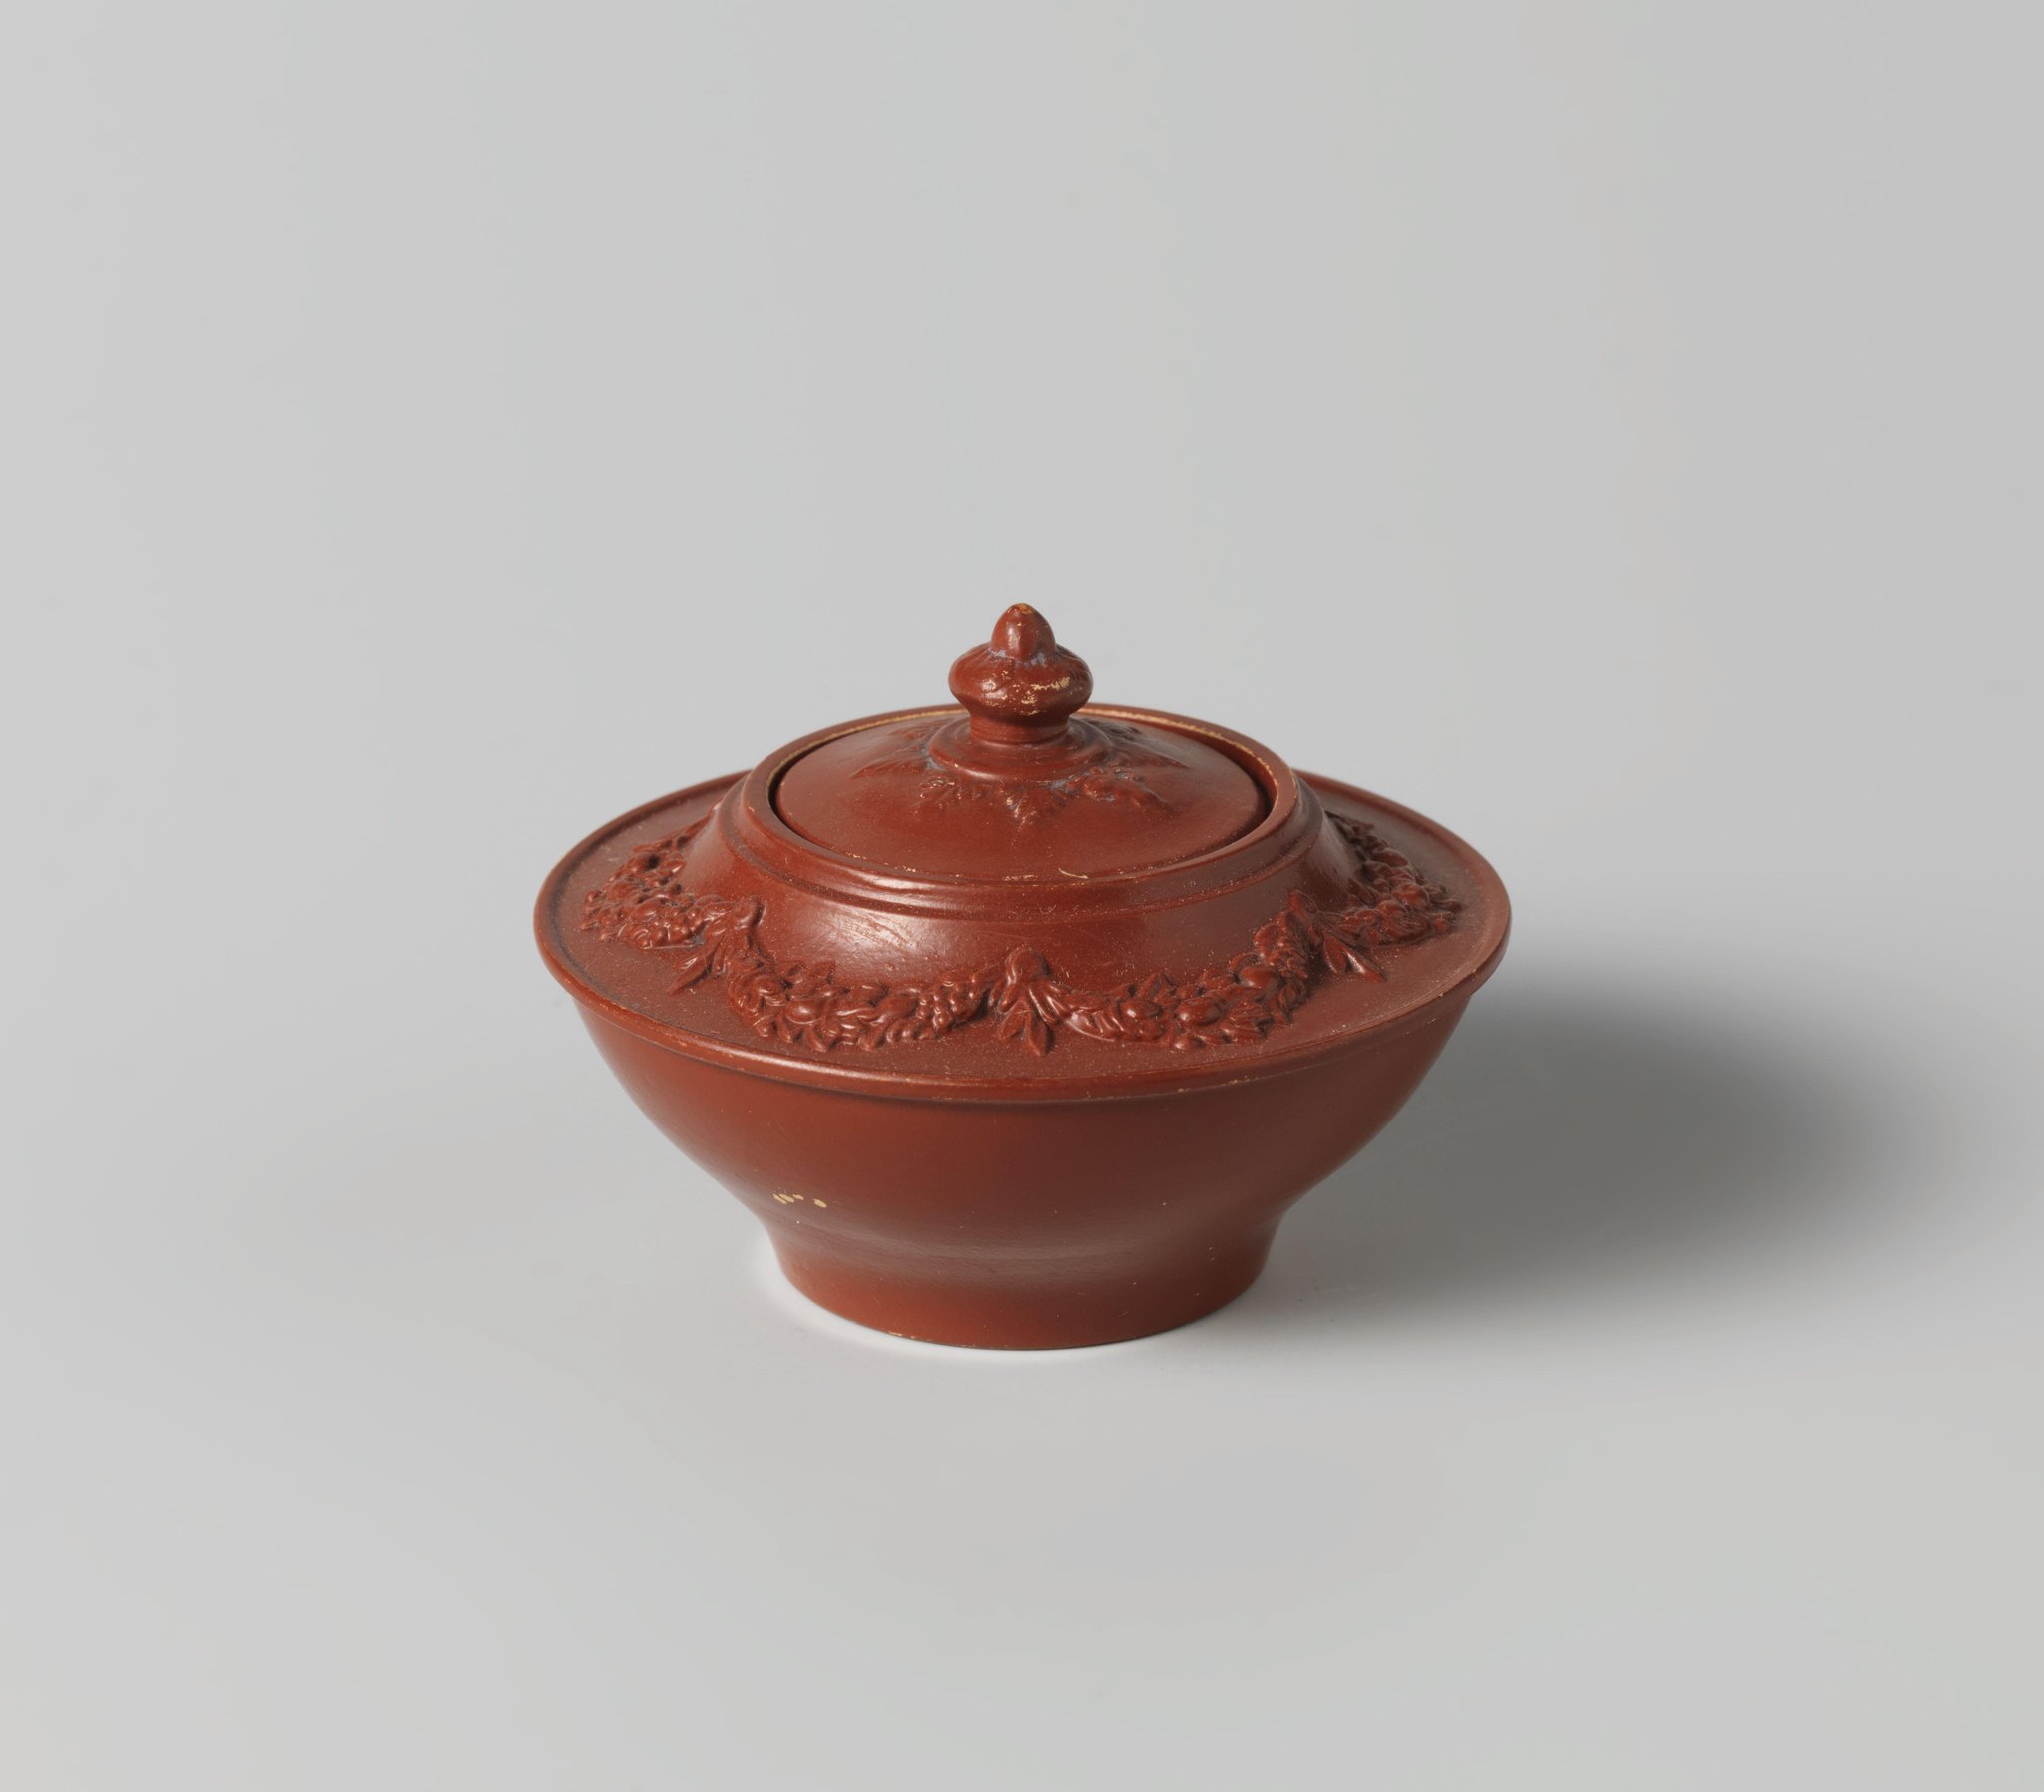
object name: lid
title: Deksel rood hardgebakken aardewerk, kinderspeelgoed.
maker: Anonymous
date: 1830-1860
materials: earthenware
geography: bohemia